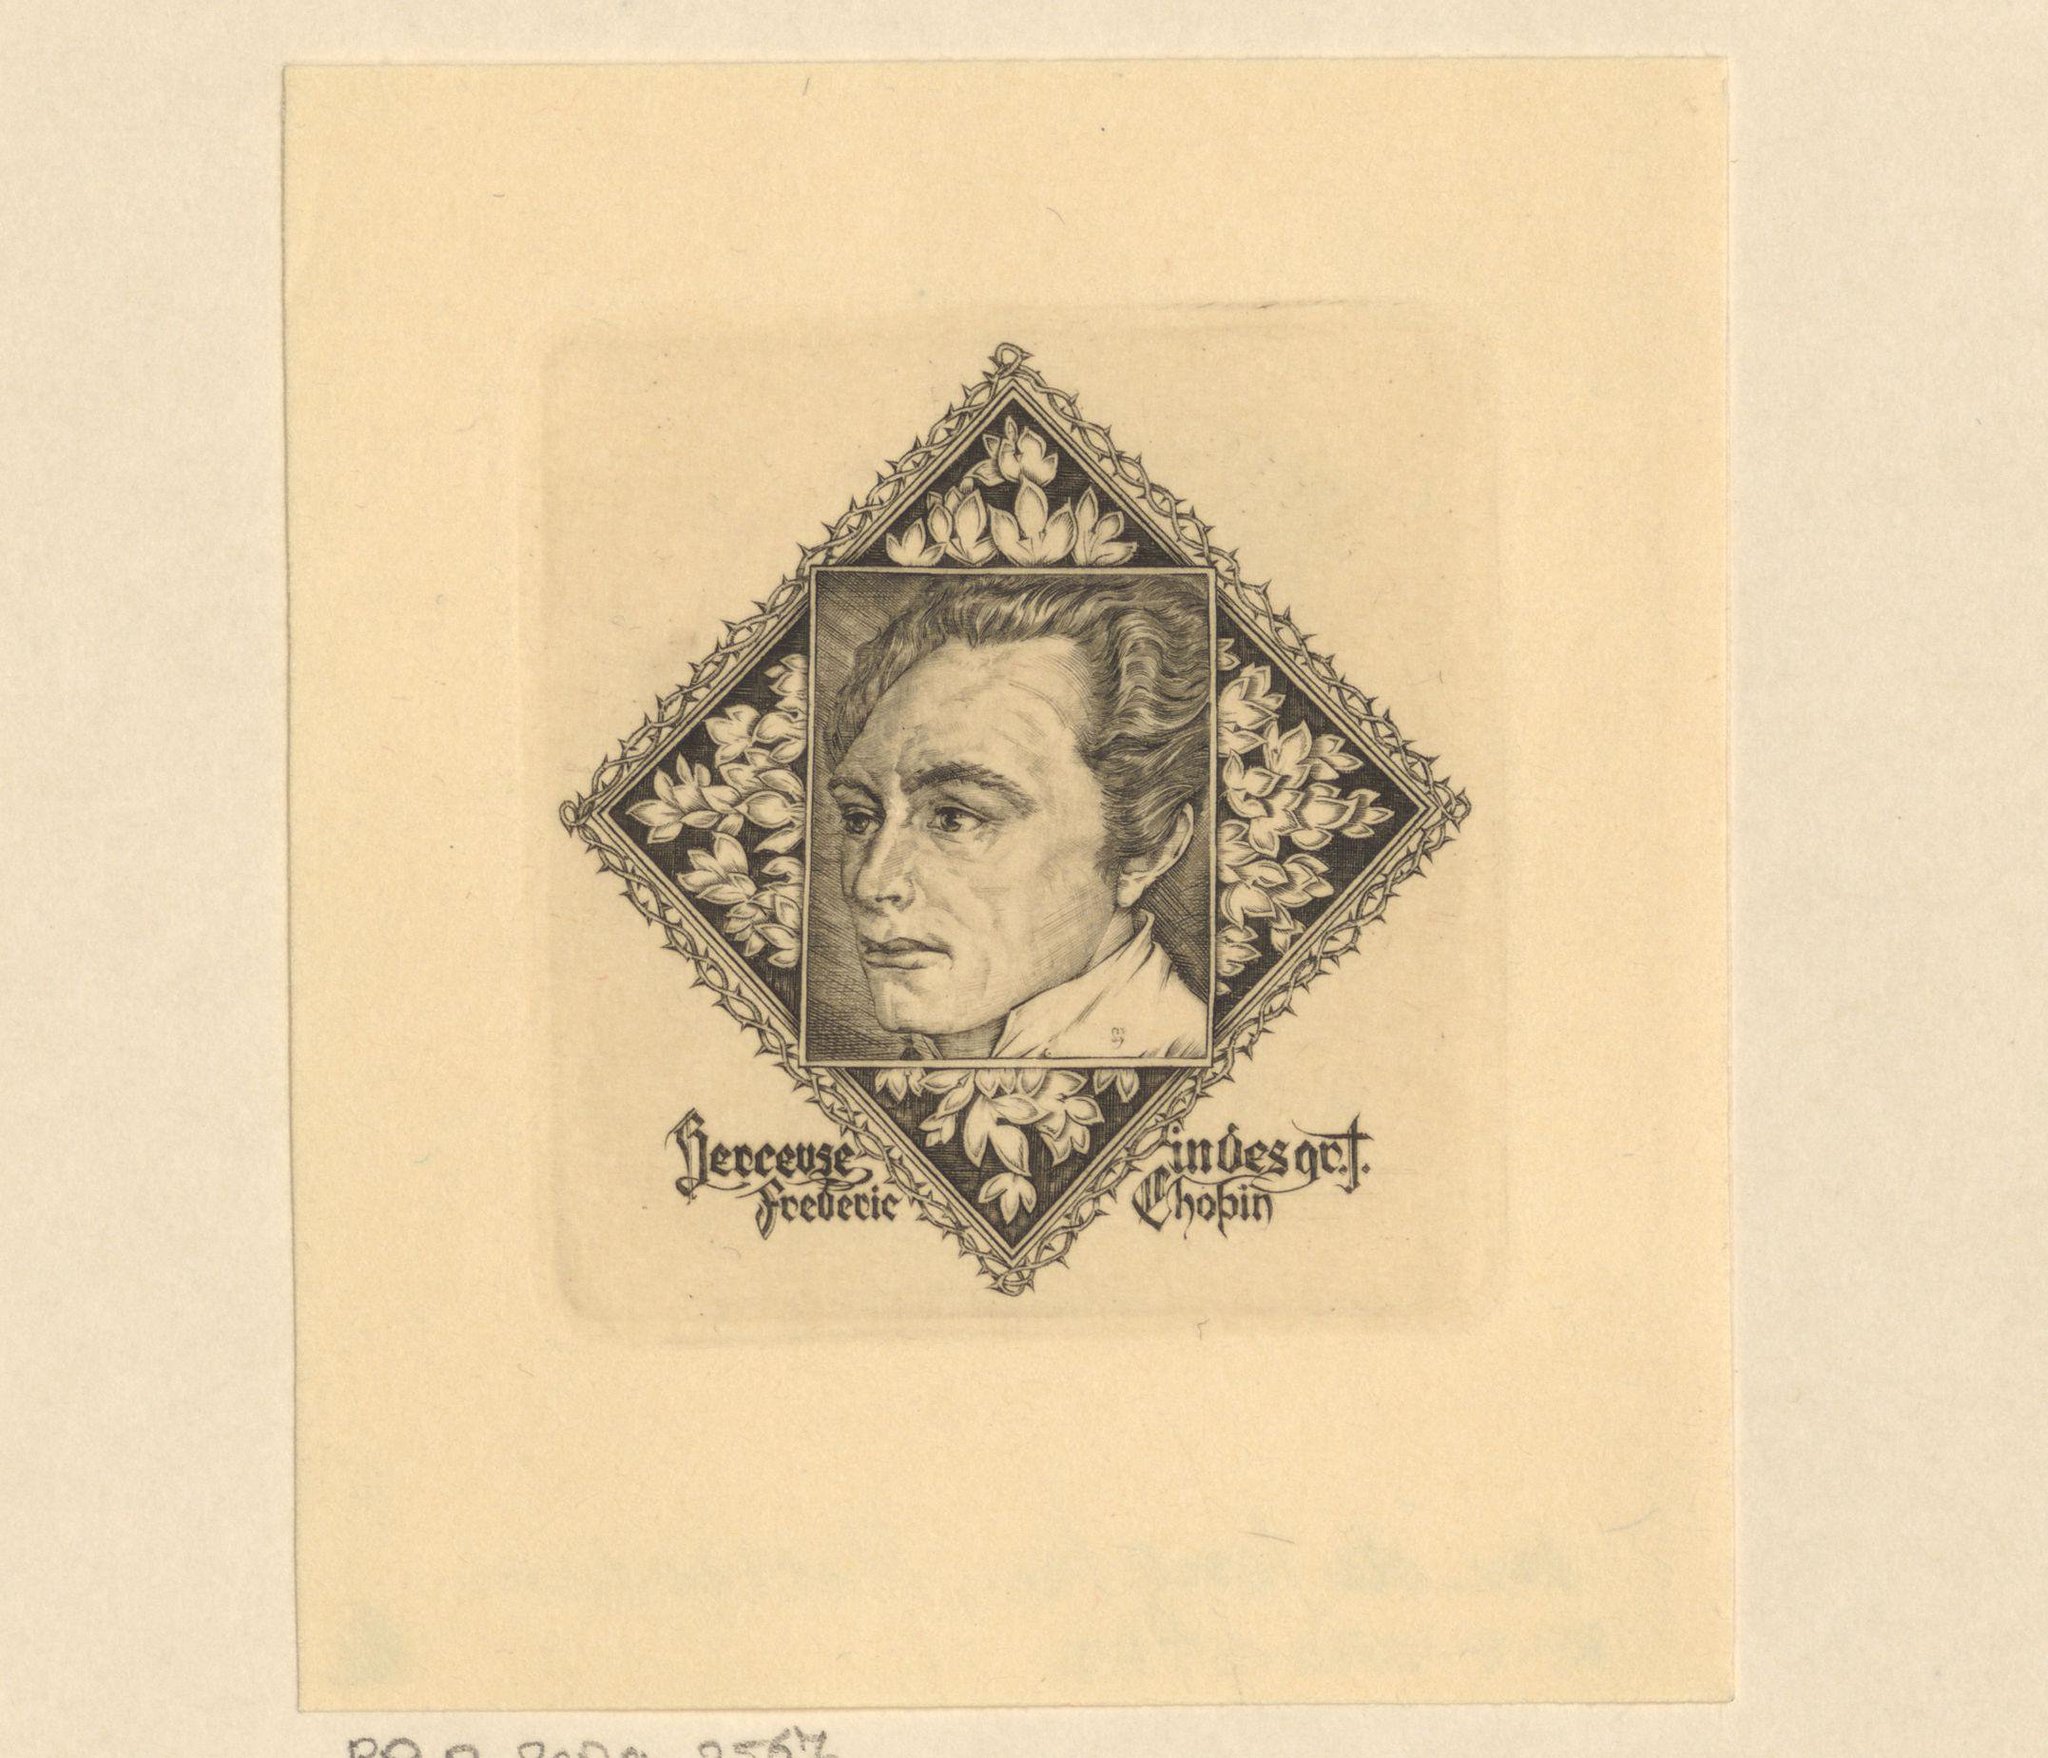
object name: print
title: Portret van Frédéric François Chopin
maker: monogrammist ed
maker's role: print maker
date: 1844-1899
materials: paper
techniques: engraving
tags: historical persons, portrait of composer